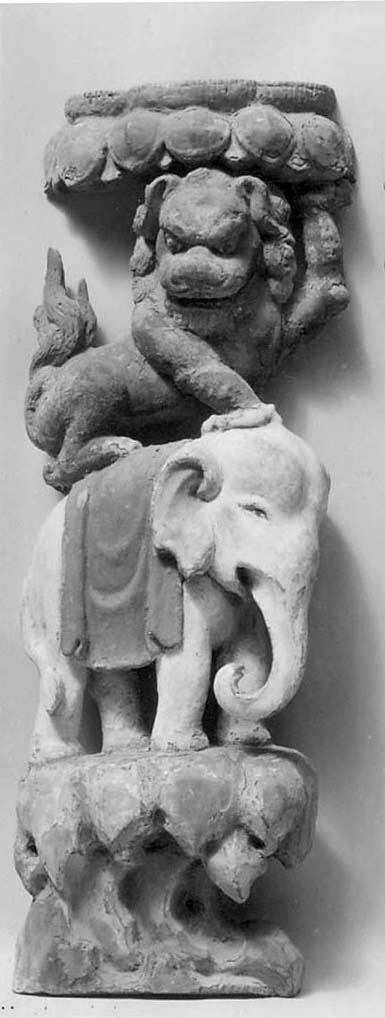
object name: shrine fragment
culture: chinese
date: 1368-1644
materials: wood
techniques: painting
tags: elephants,lions